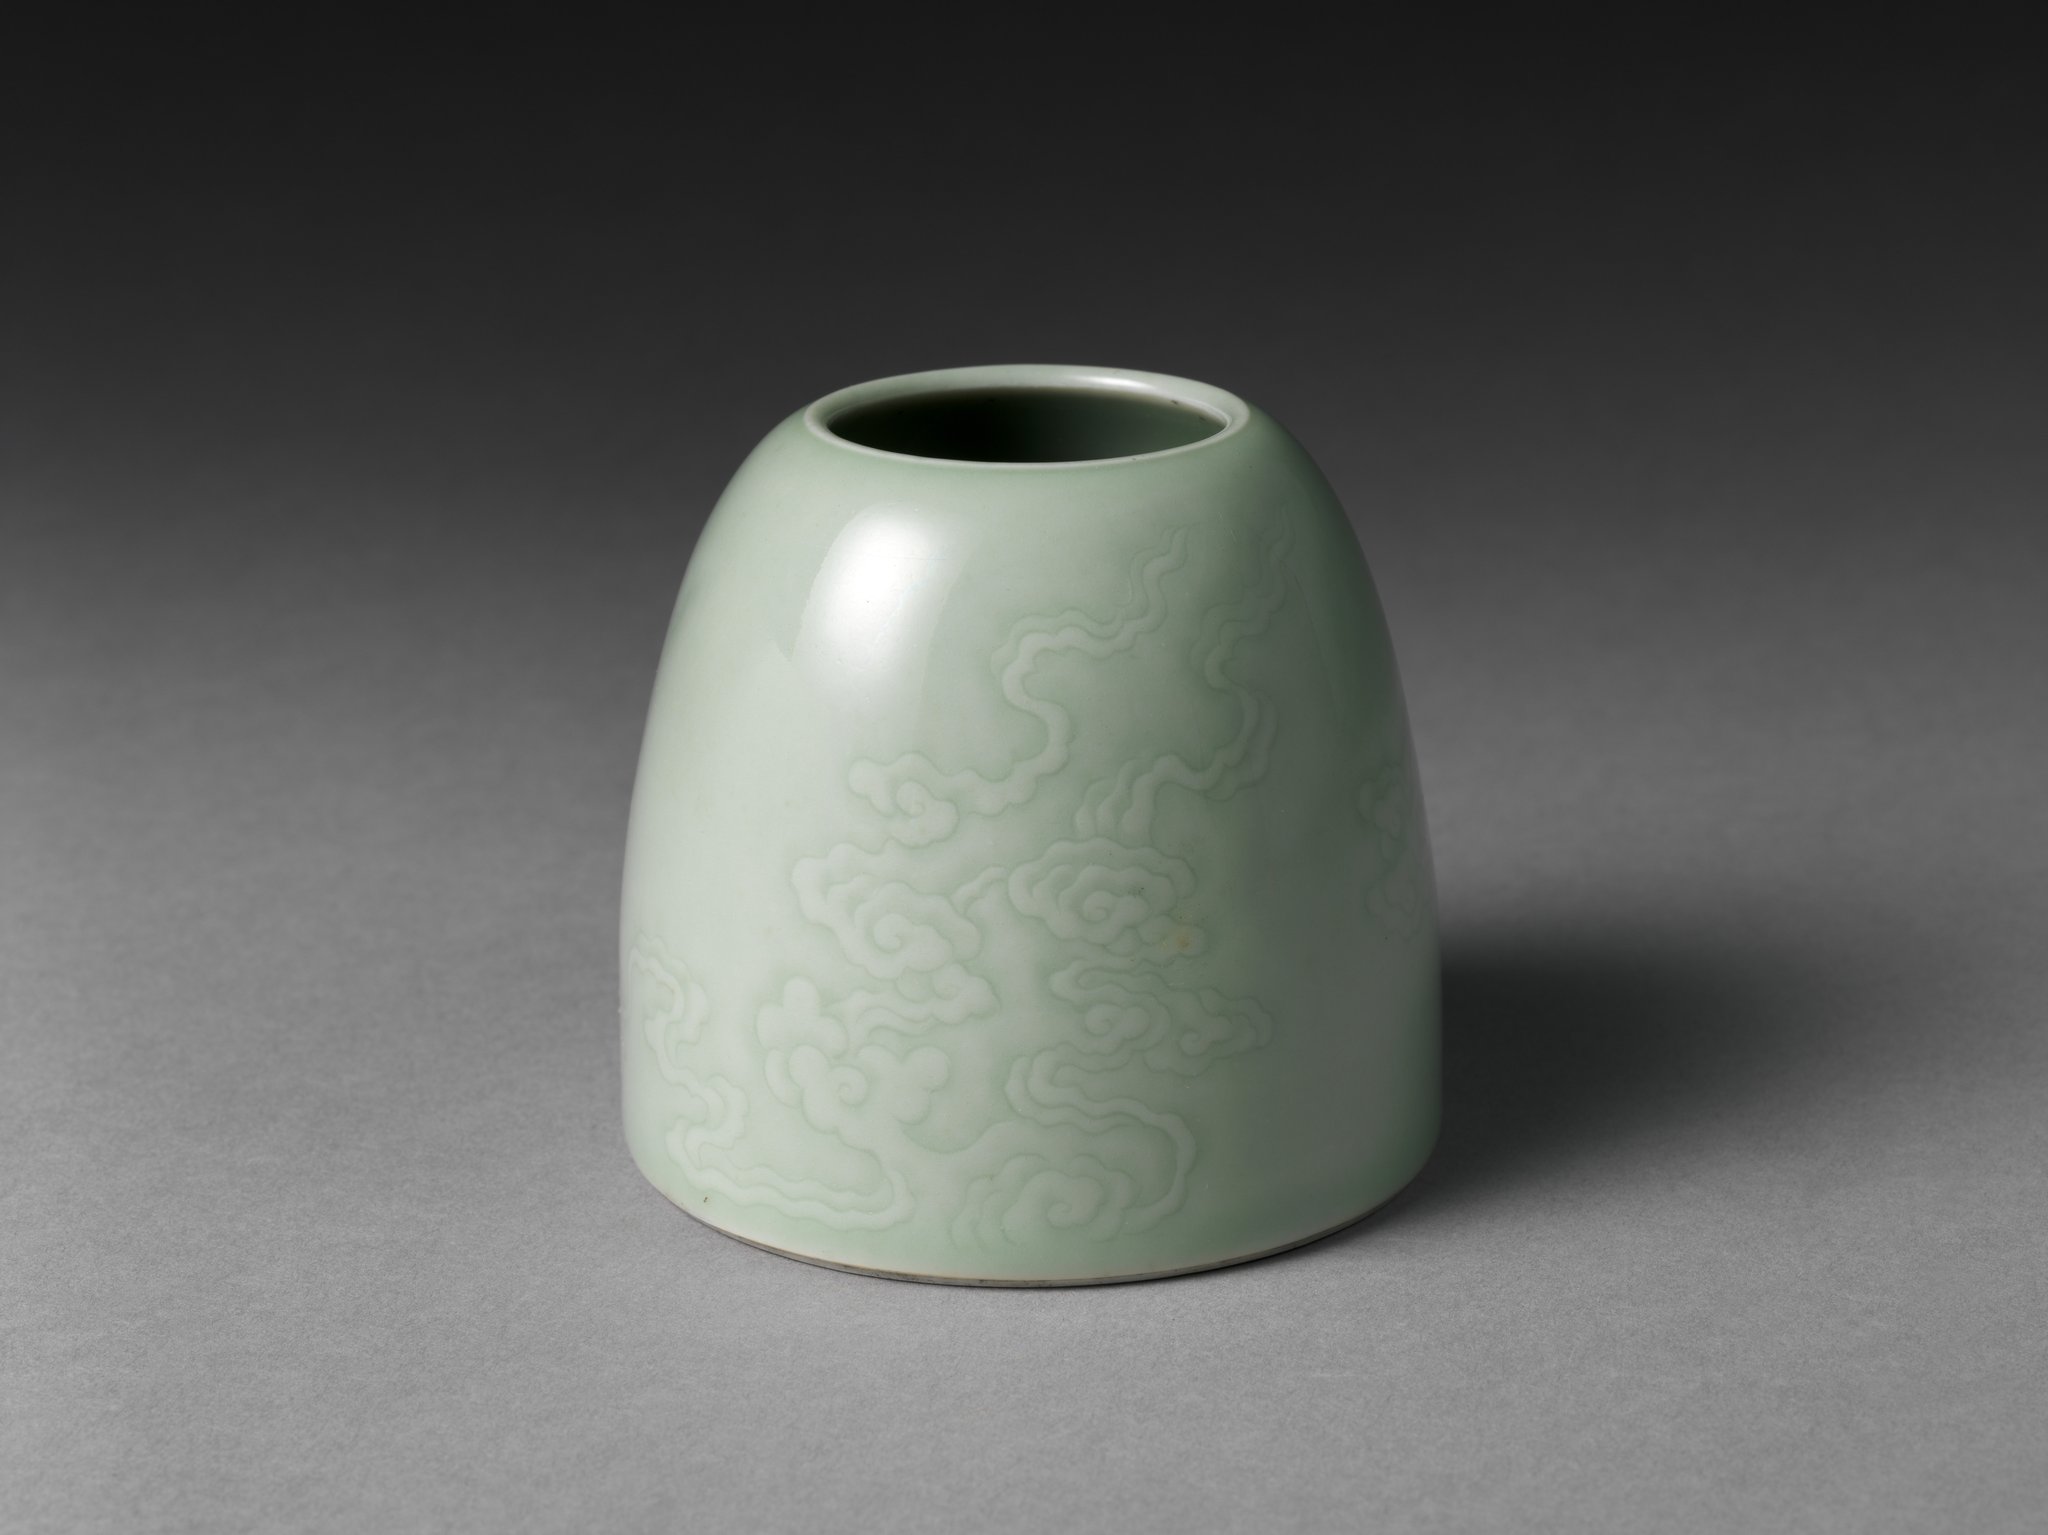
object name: jar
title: Water Jar with Swirling Clouds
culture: chinese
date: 1713-1722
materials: ceramic glaze, glaze, porcelain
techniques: incising